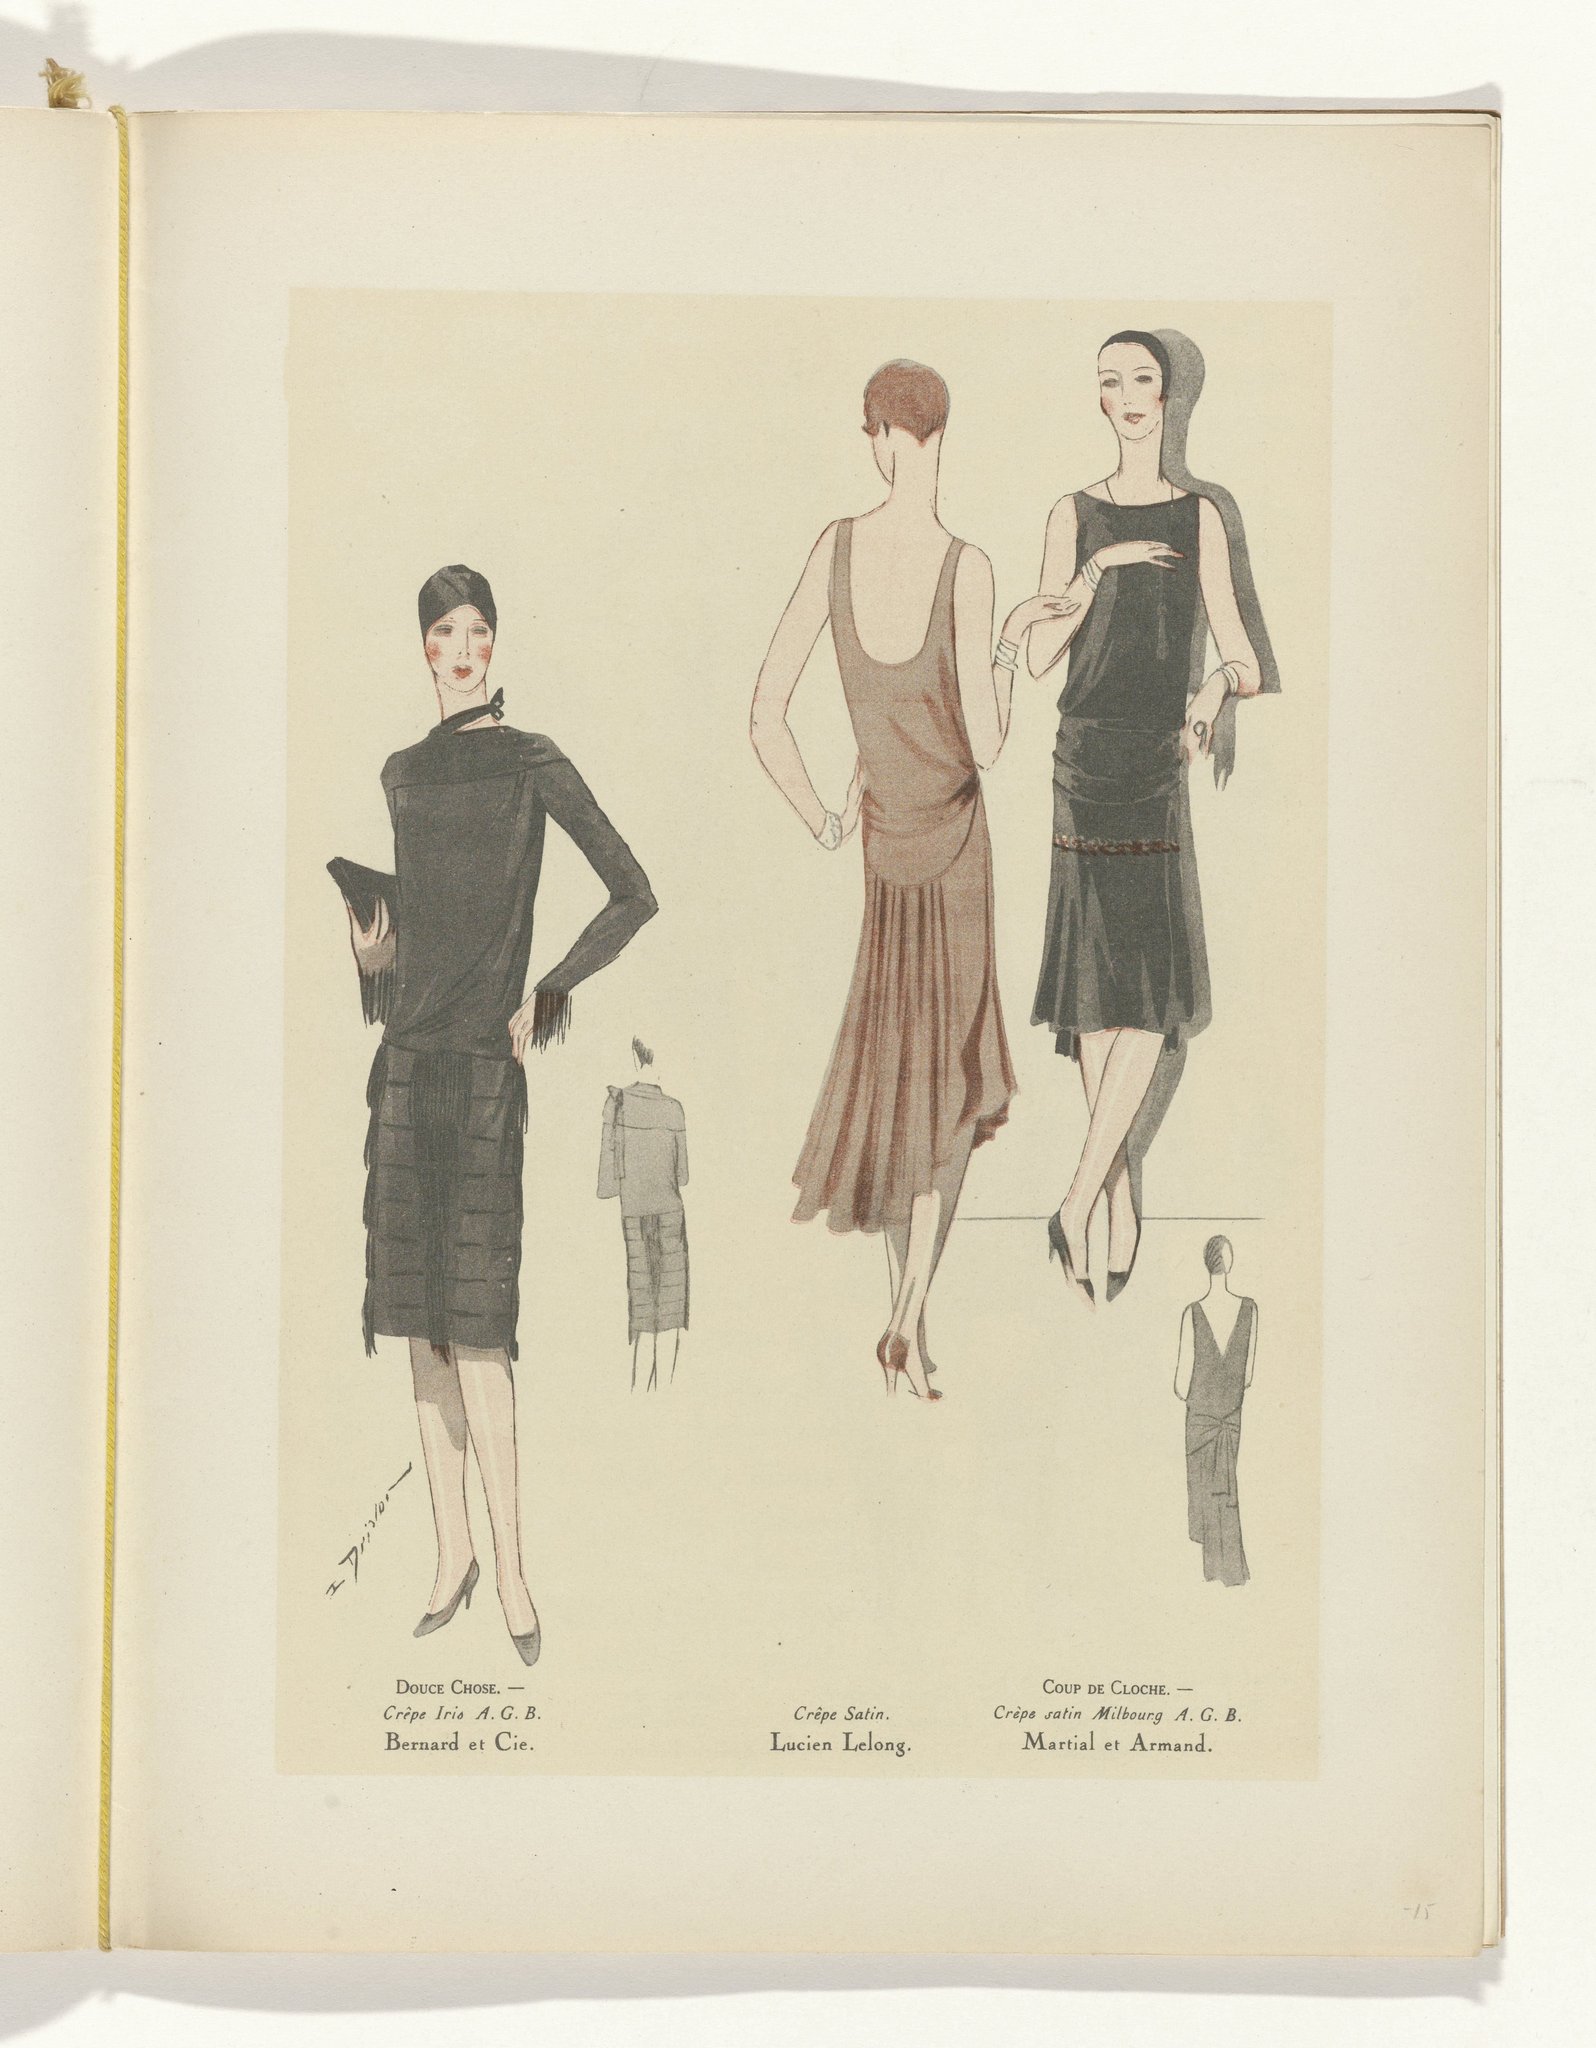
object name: fashion print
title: Art - Goût - Beauté, Feuillets de l' élégance féminine, Novembre 1928, No. 99, 9e Année, p. 15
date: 1928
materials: paper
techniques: printing, photography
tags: fashion plates, dress, gown (+ women's clothes)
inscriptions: caption: ‘DOUCE CHOSE. - Crêpe Iris A.G.B. Bernard et Cie. / Crêpe Satin. Lucien Lelong. / COUP DE CLOCHE. - Crêpe satin Milbourg A.G.B. Martial et Armand.’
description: Links: jurk van crêpe Iris, A.G.B., van Bernard et Cie. Midden: jurk van 'crêpe satin', van Lucien Lelong. Rechts: jurk van 'crêpe satin' Milbourg A.G.B., van Martial et Armand. Pagina uit het modetijdschrift Art-Goût-Beauté (1920-1933).